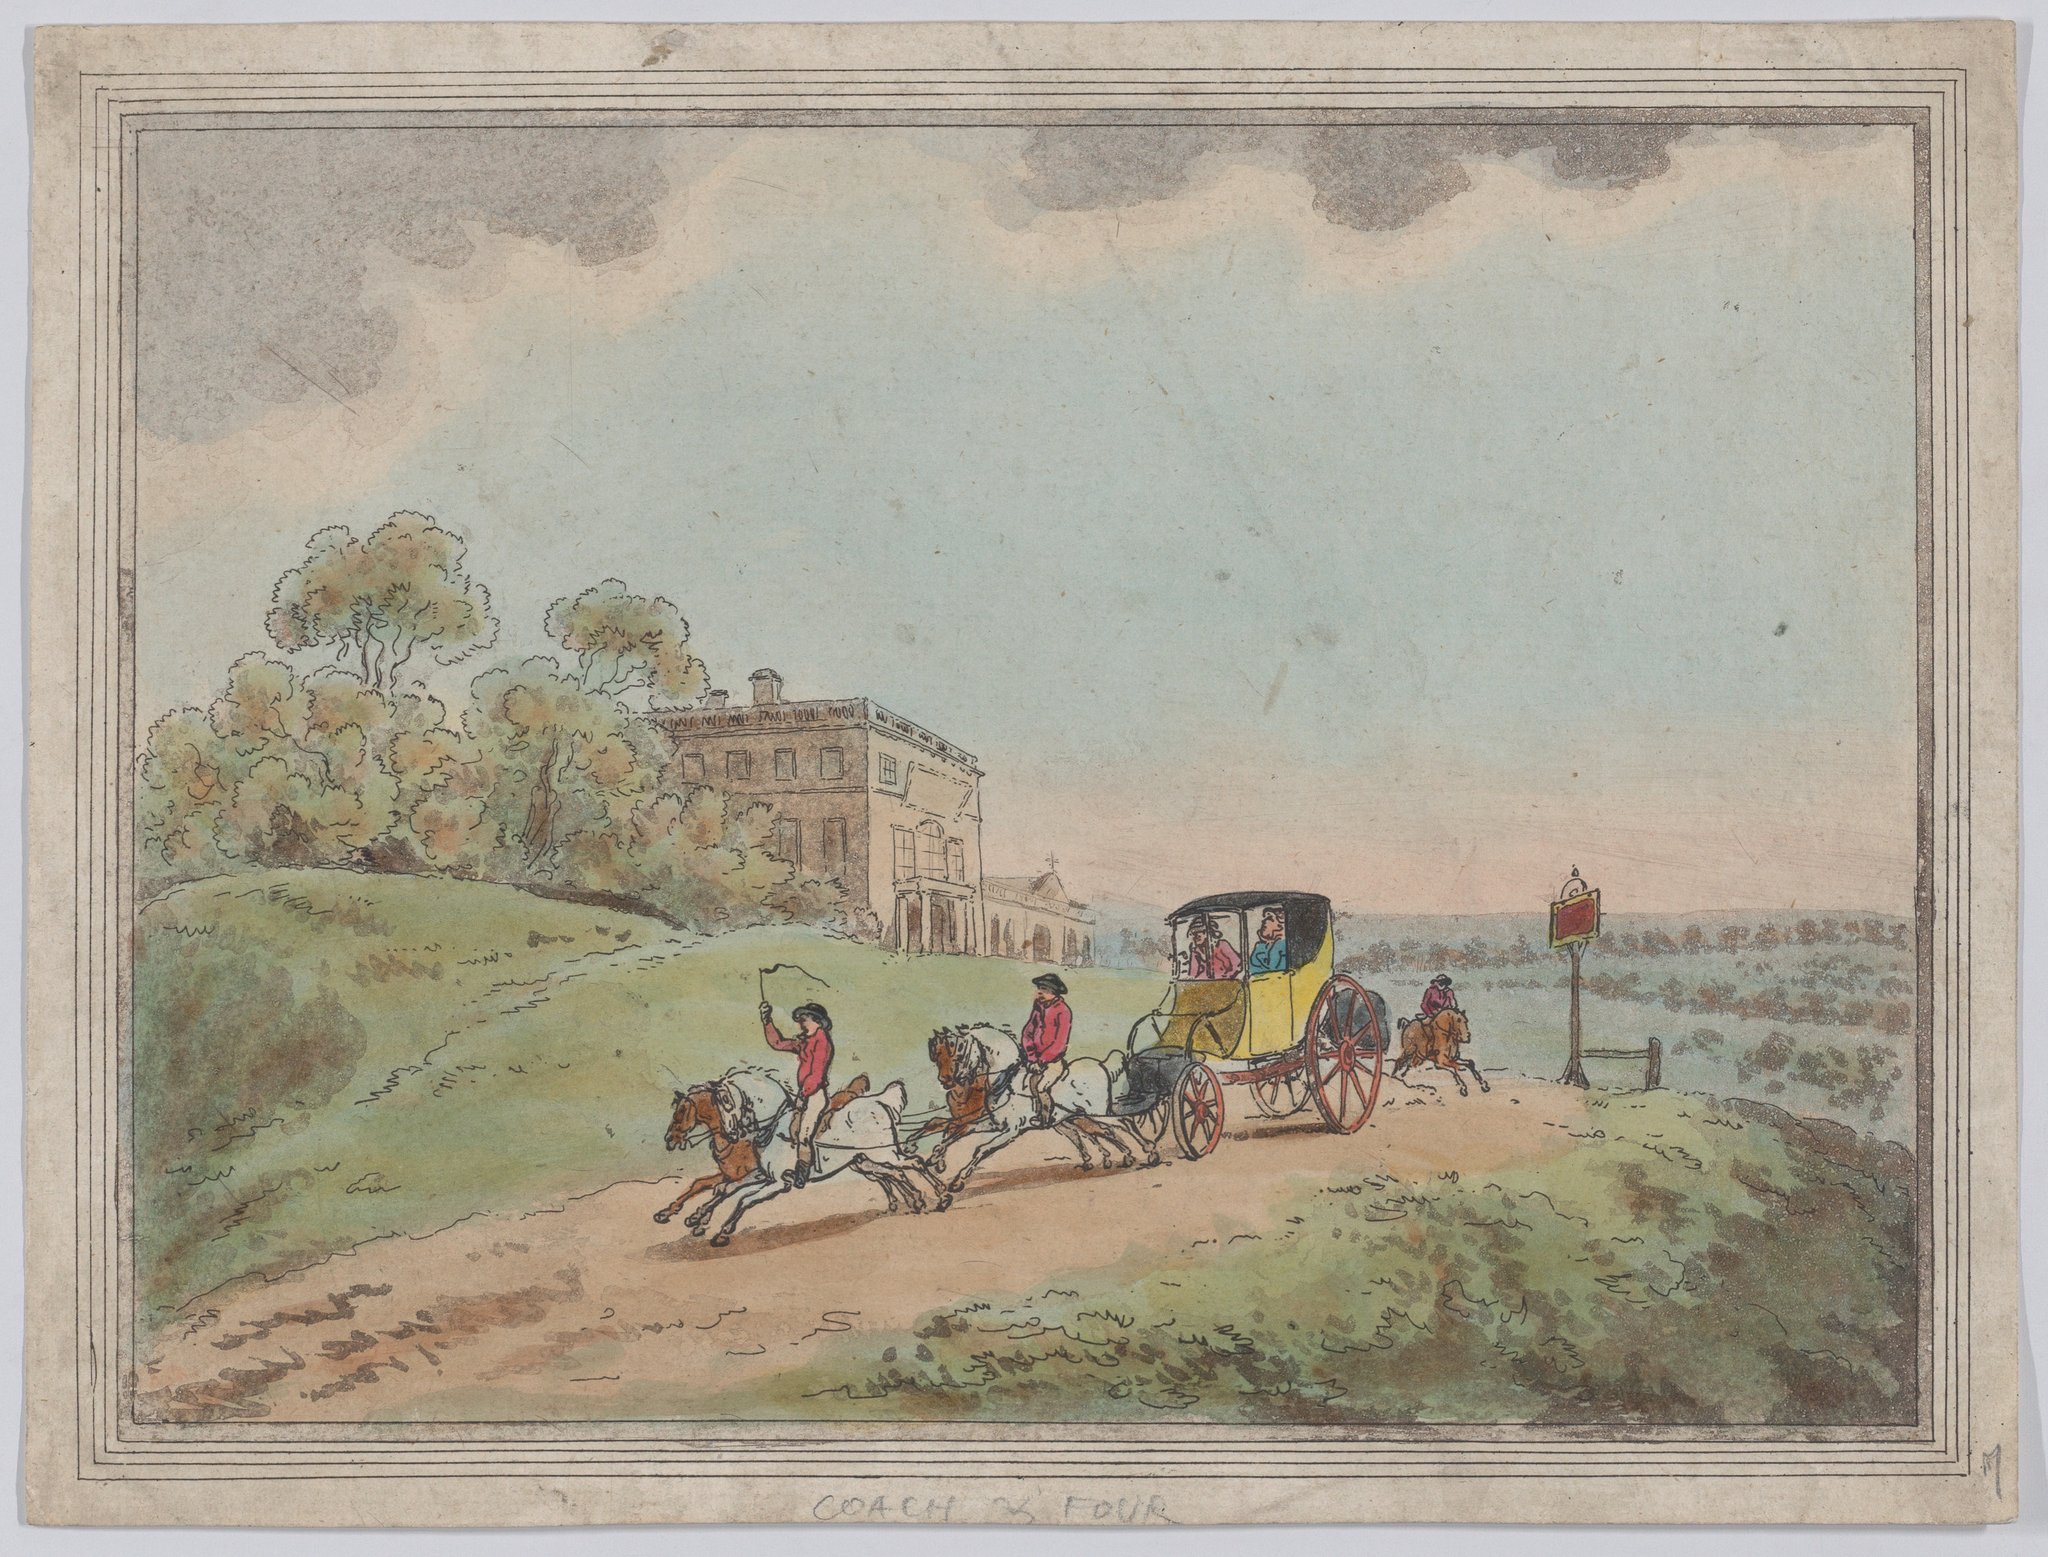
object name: print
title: A Coach and Four (from, Rustic Sketches?)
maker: thomas rowlandson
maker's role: artist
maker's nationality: british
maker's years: 1757-1827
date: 1787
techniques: aquatint, etching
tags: horses,landscapes,carriages